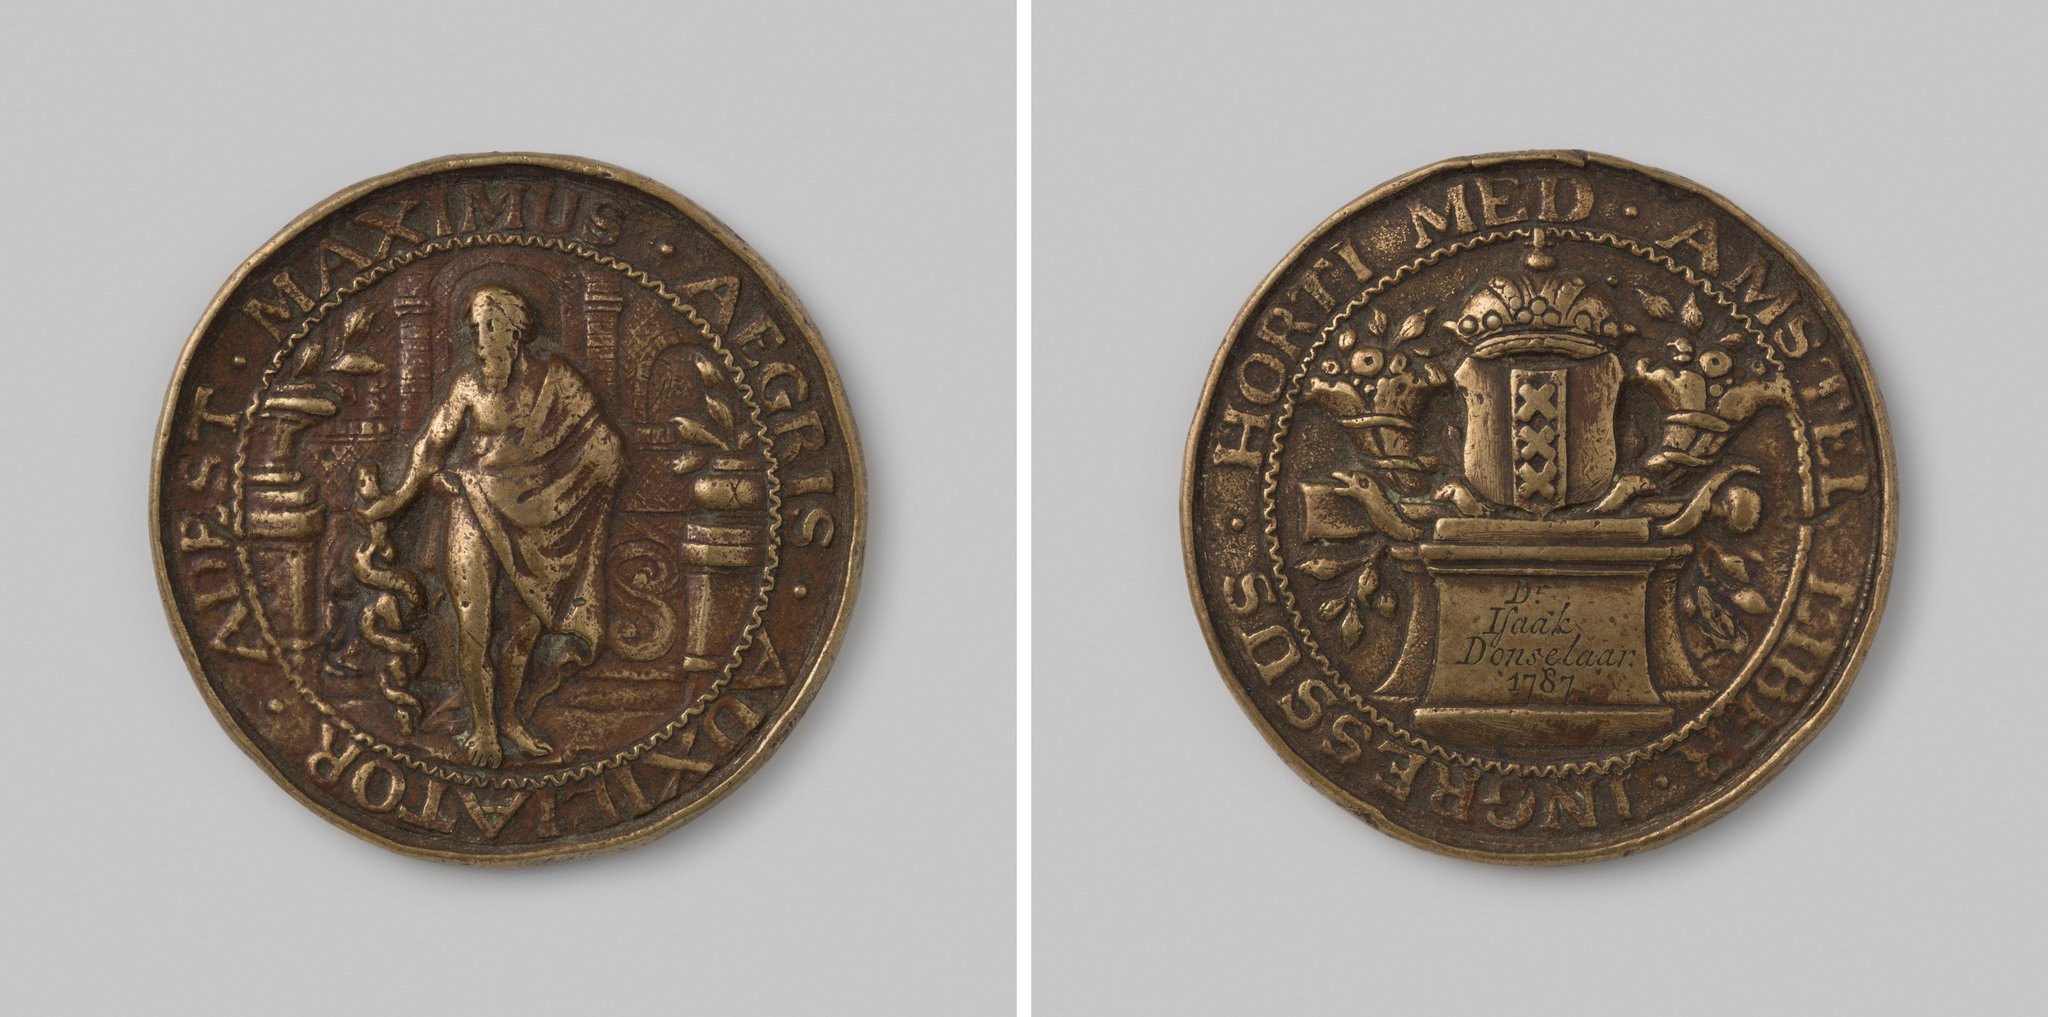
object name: medal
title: Toegangspenning tot de Hortus Medicus te Amsterdam 1696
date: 1696-1699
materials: brass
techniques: casting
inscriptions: inscription: ‘Dr. / Isaak / Donselaar. / 1787’, circumscription: ‘MAXIMUS AEGRIS AUXILIATOR ADEST’, circumscription: ‘HORTI MED AMSTEL LIBER INGRESSUS’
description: Gegoten messing penning met op de voorzijde Aesculapius en op de keerzijde een altaar waarop het gekroonde stadswapen, een caduceus en cornucopiae waaruit kruidentakken, op naam van Dr. Isaak Donselaar 1787